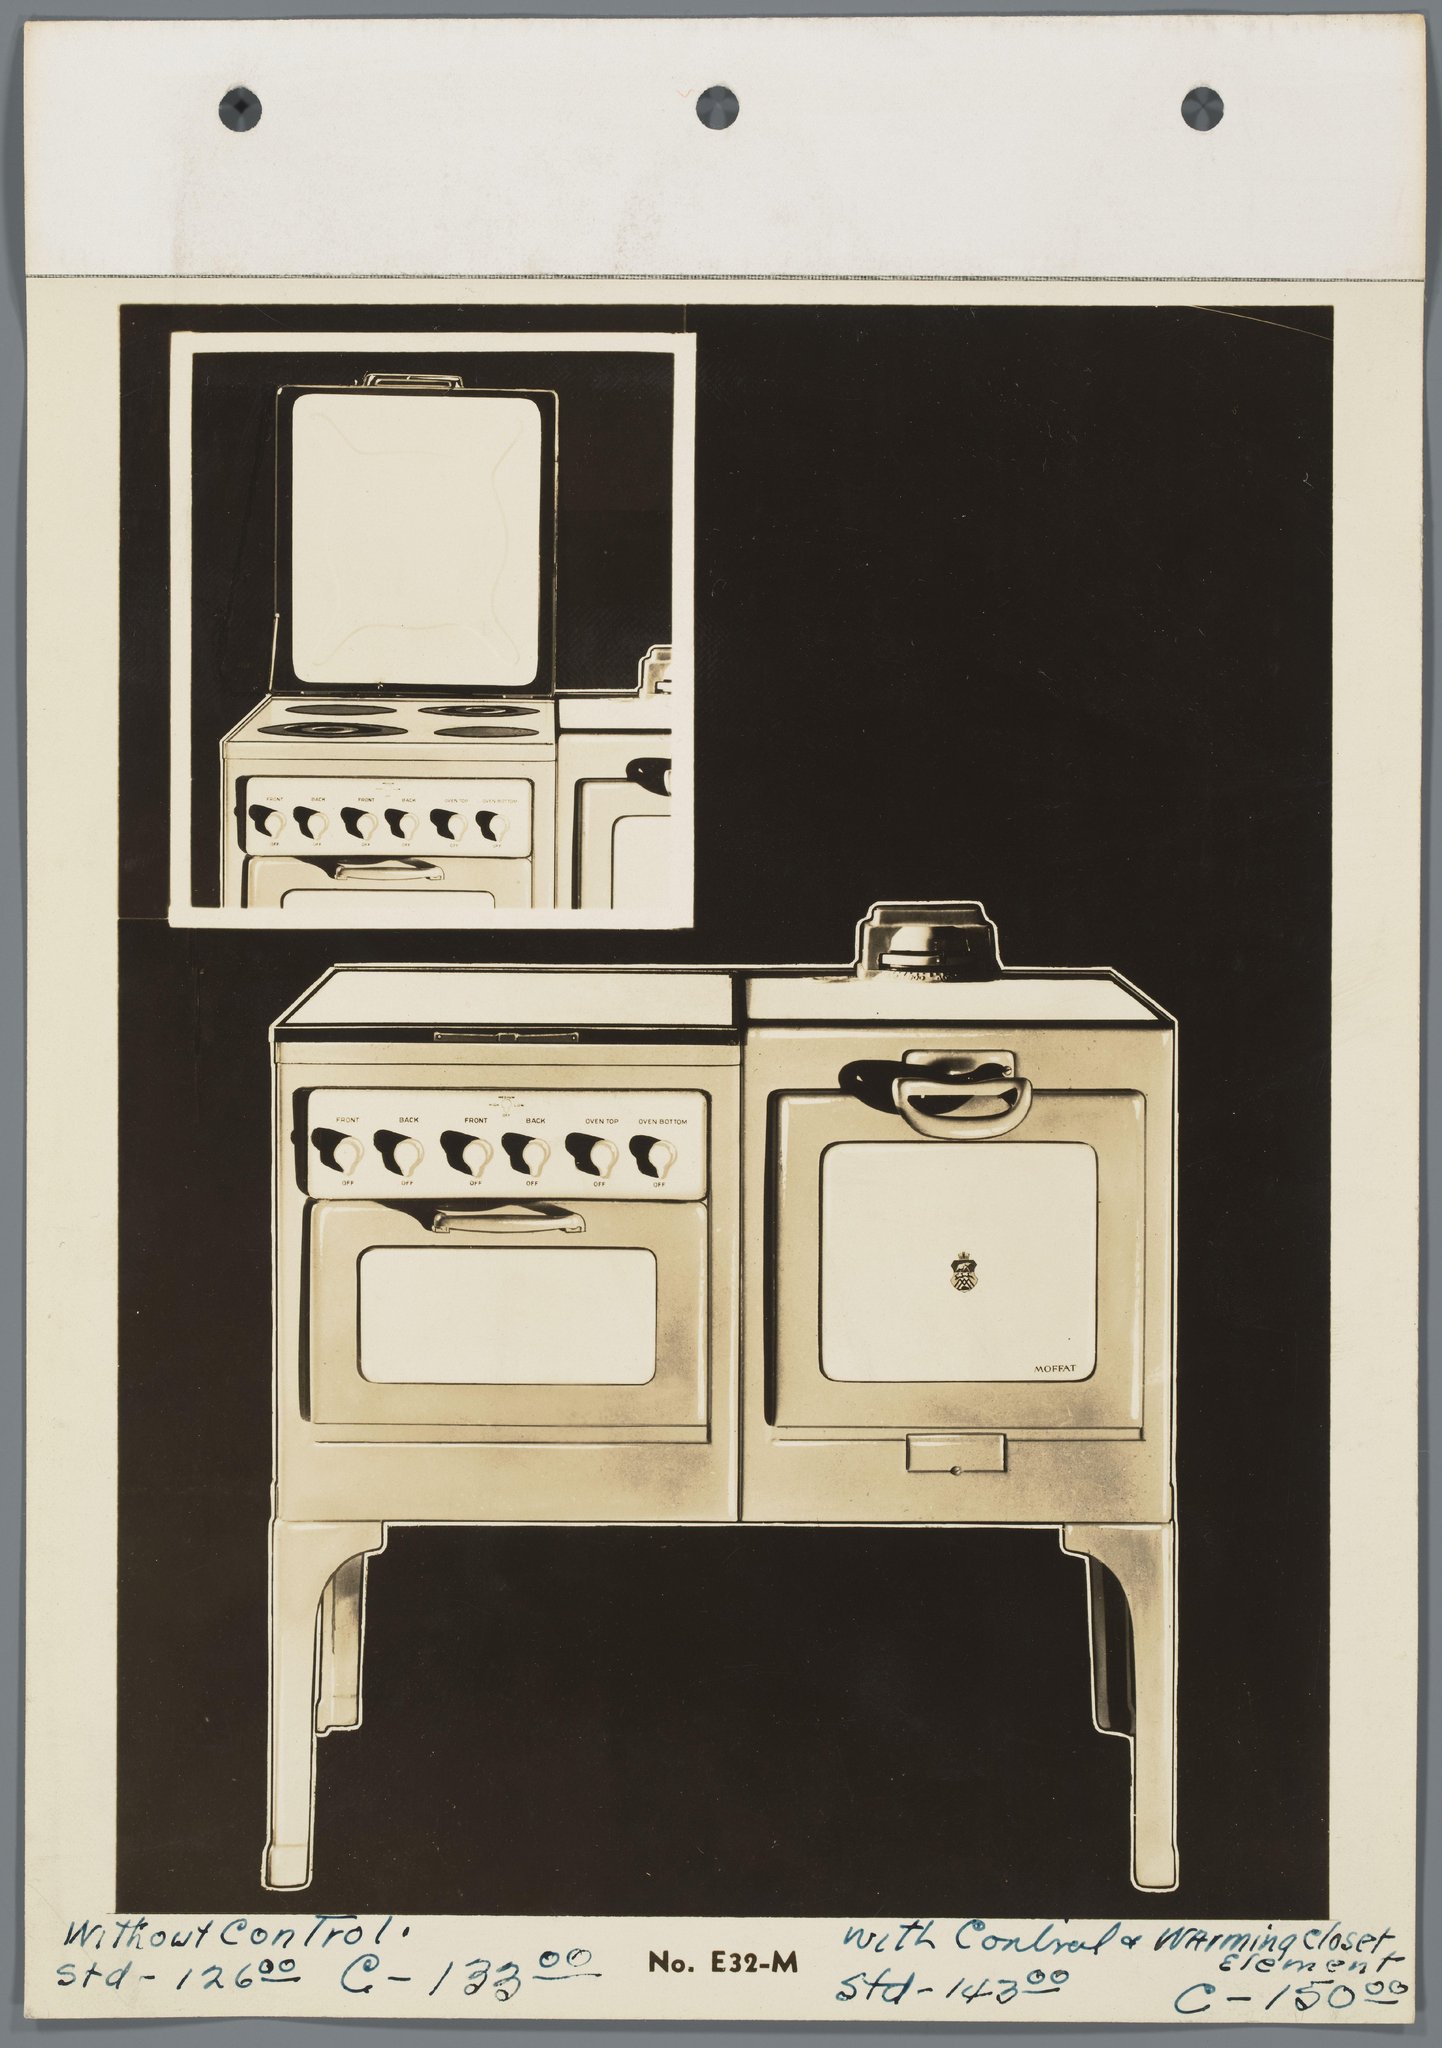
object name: photograph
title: Foto van Moffat ovens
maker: Anonymous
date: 1935-1940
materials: paper, photographic support, textile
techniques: gelatin silver print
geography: canada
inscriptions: inscription: ‘No. E32-M’, inscription: ‘Without control. std - 112600 C-13300’, inscription: ‘With control + Warming closet element std - 14300 C 15000’